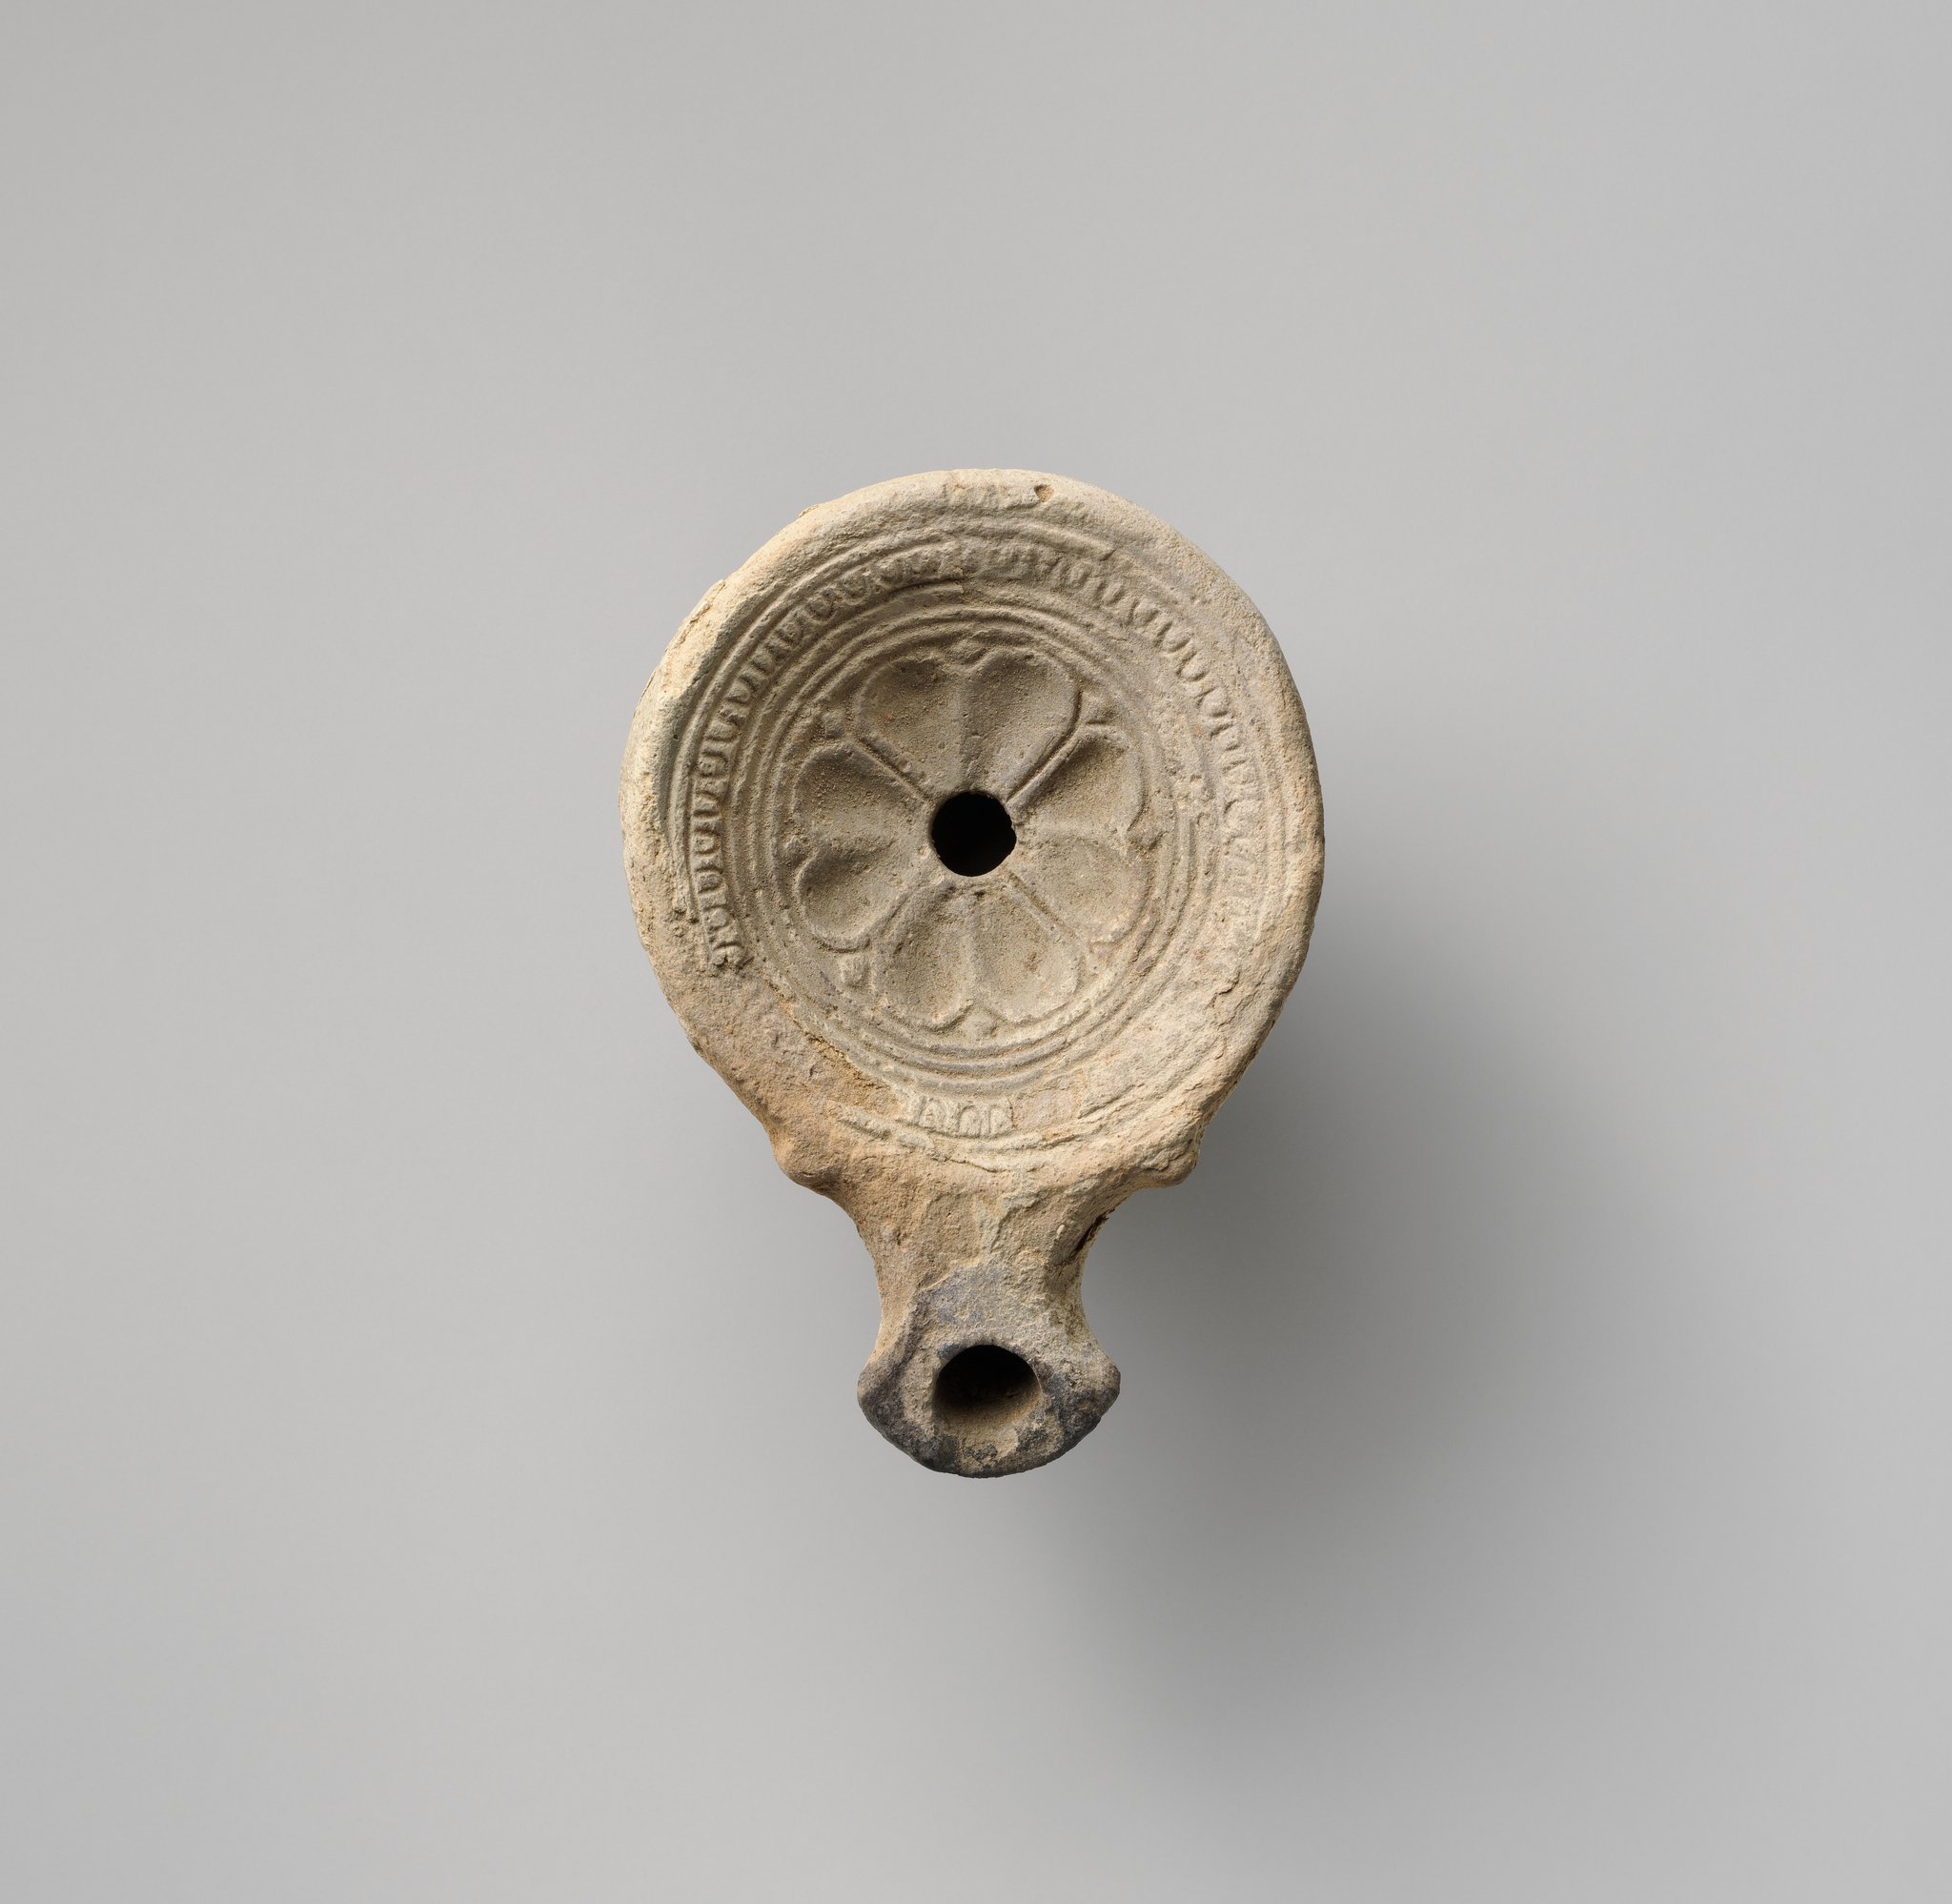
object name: lamp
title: Terracotta oil lamp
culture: roman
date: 100 BCE-100 CE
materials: terracotta